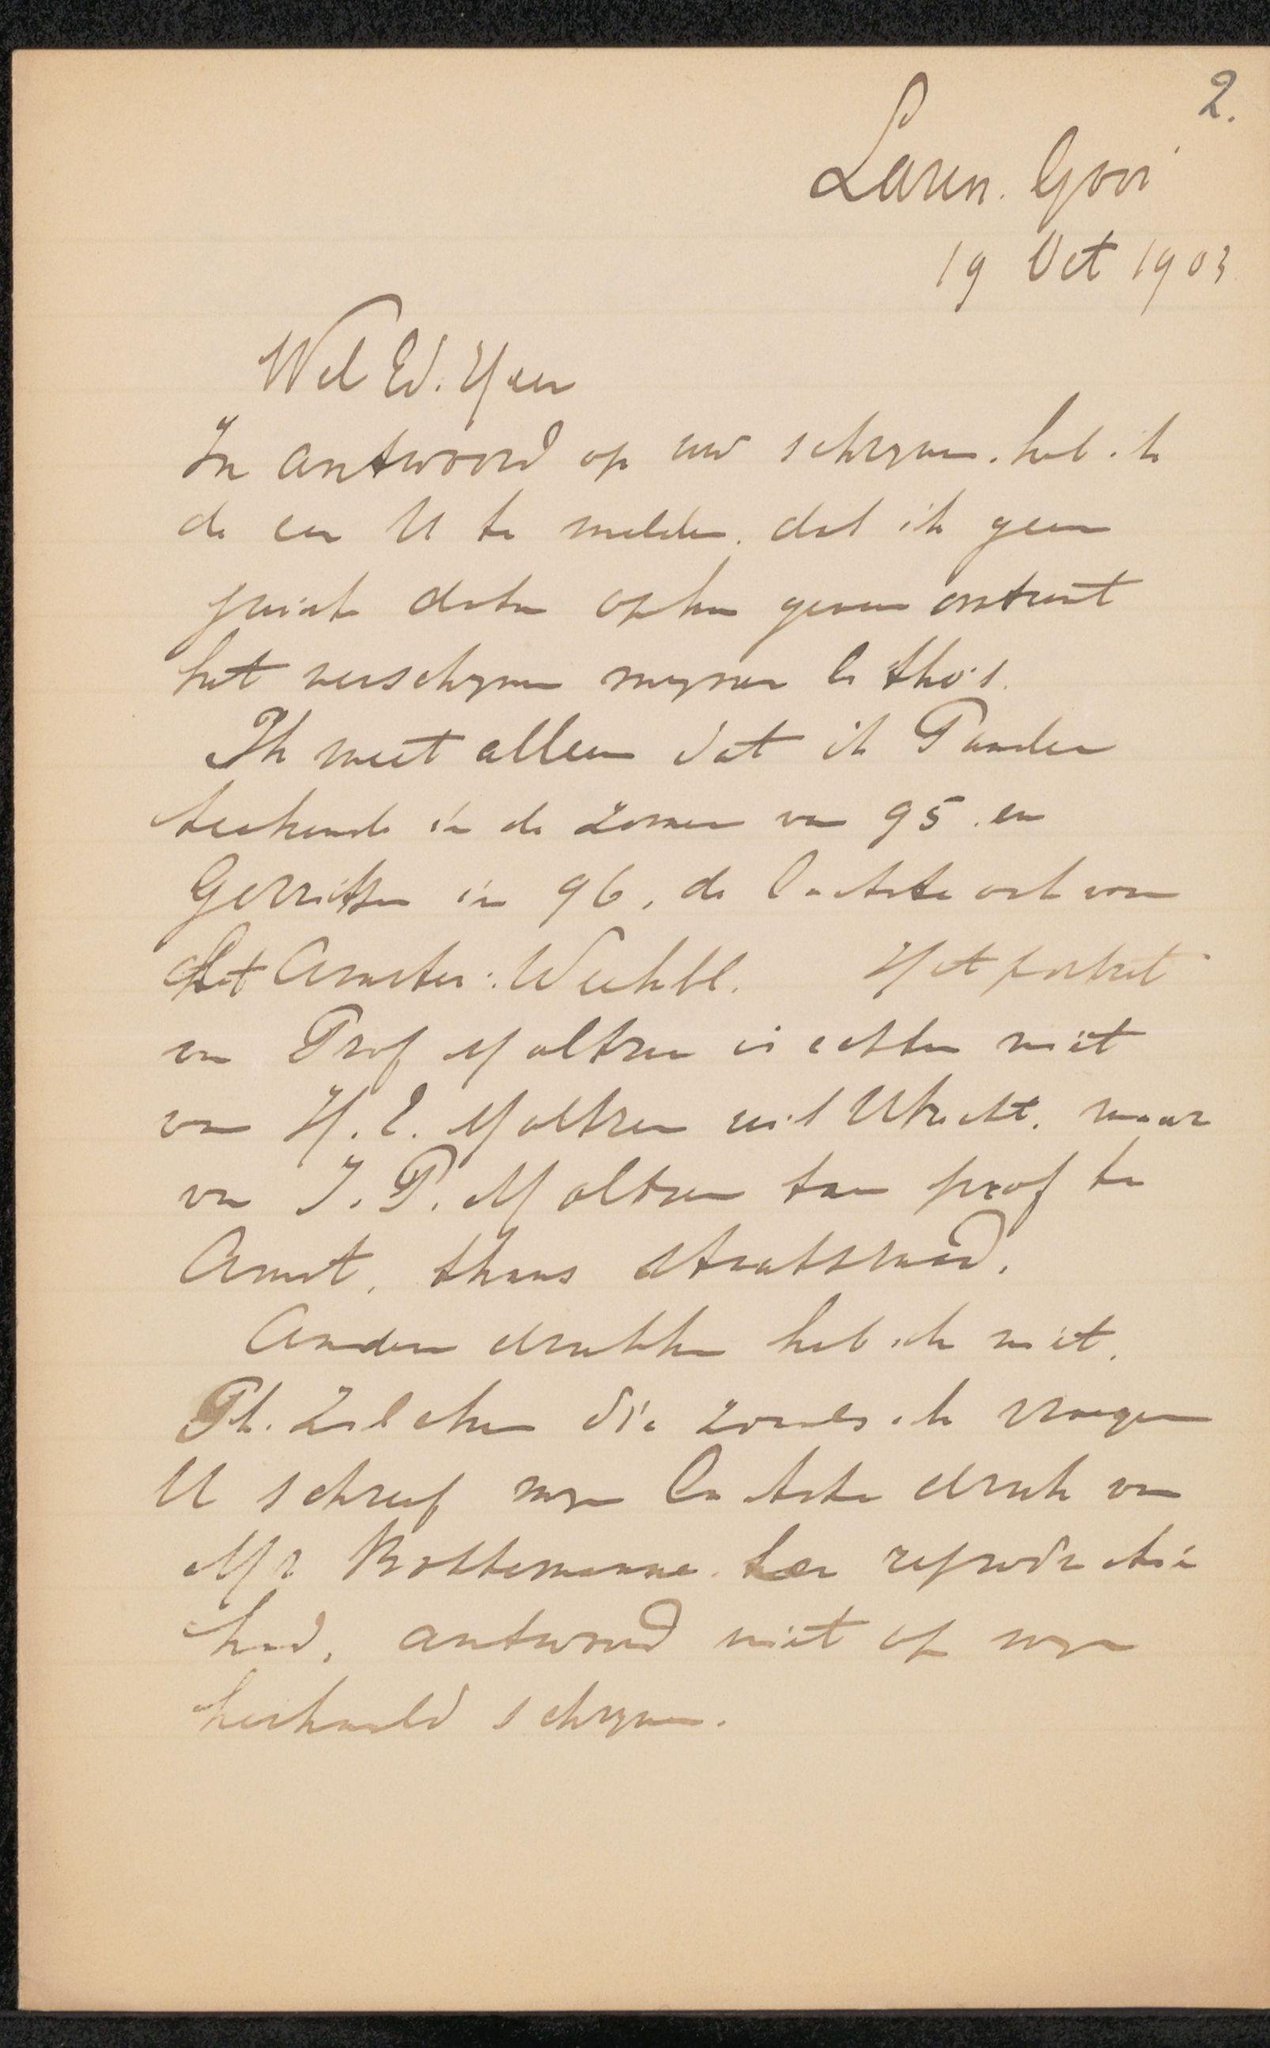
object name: letter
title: Brief aan Pieter Haverkorn van Rijsewijk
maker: ferdinand hart nibbrig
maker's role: draughtsman, painter, print maker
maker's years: 1866-1915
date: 1903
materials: ink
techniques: pen, writing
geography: laren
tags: designer, pier pander, pieter haverkorn van rijsewijk, amsterdam, jacob pieter moltzer, painter, draughtsman, philip zilcken, drawing, the graphic arts, art collecting, historical persons (portraits and scenes from the life)